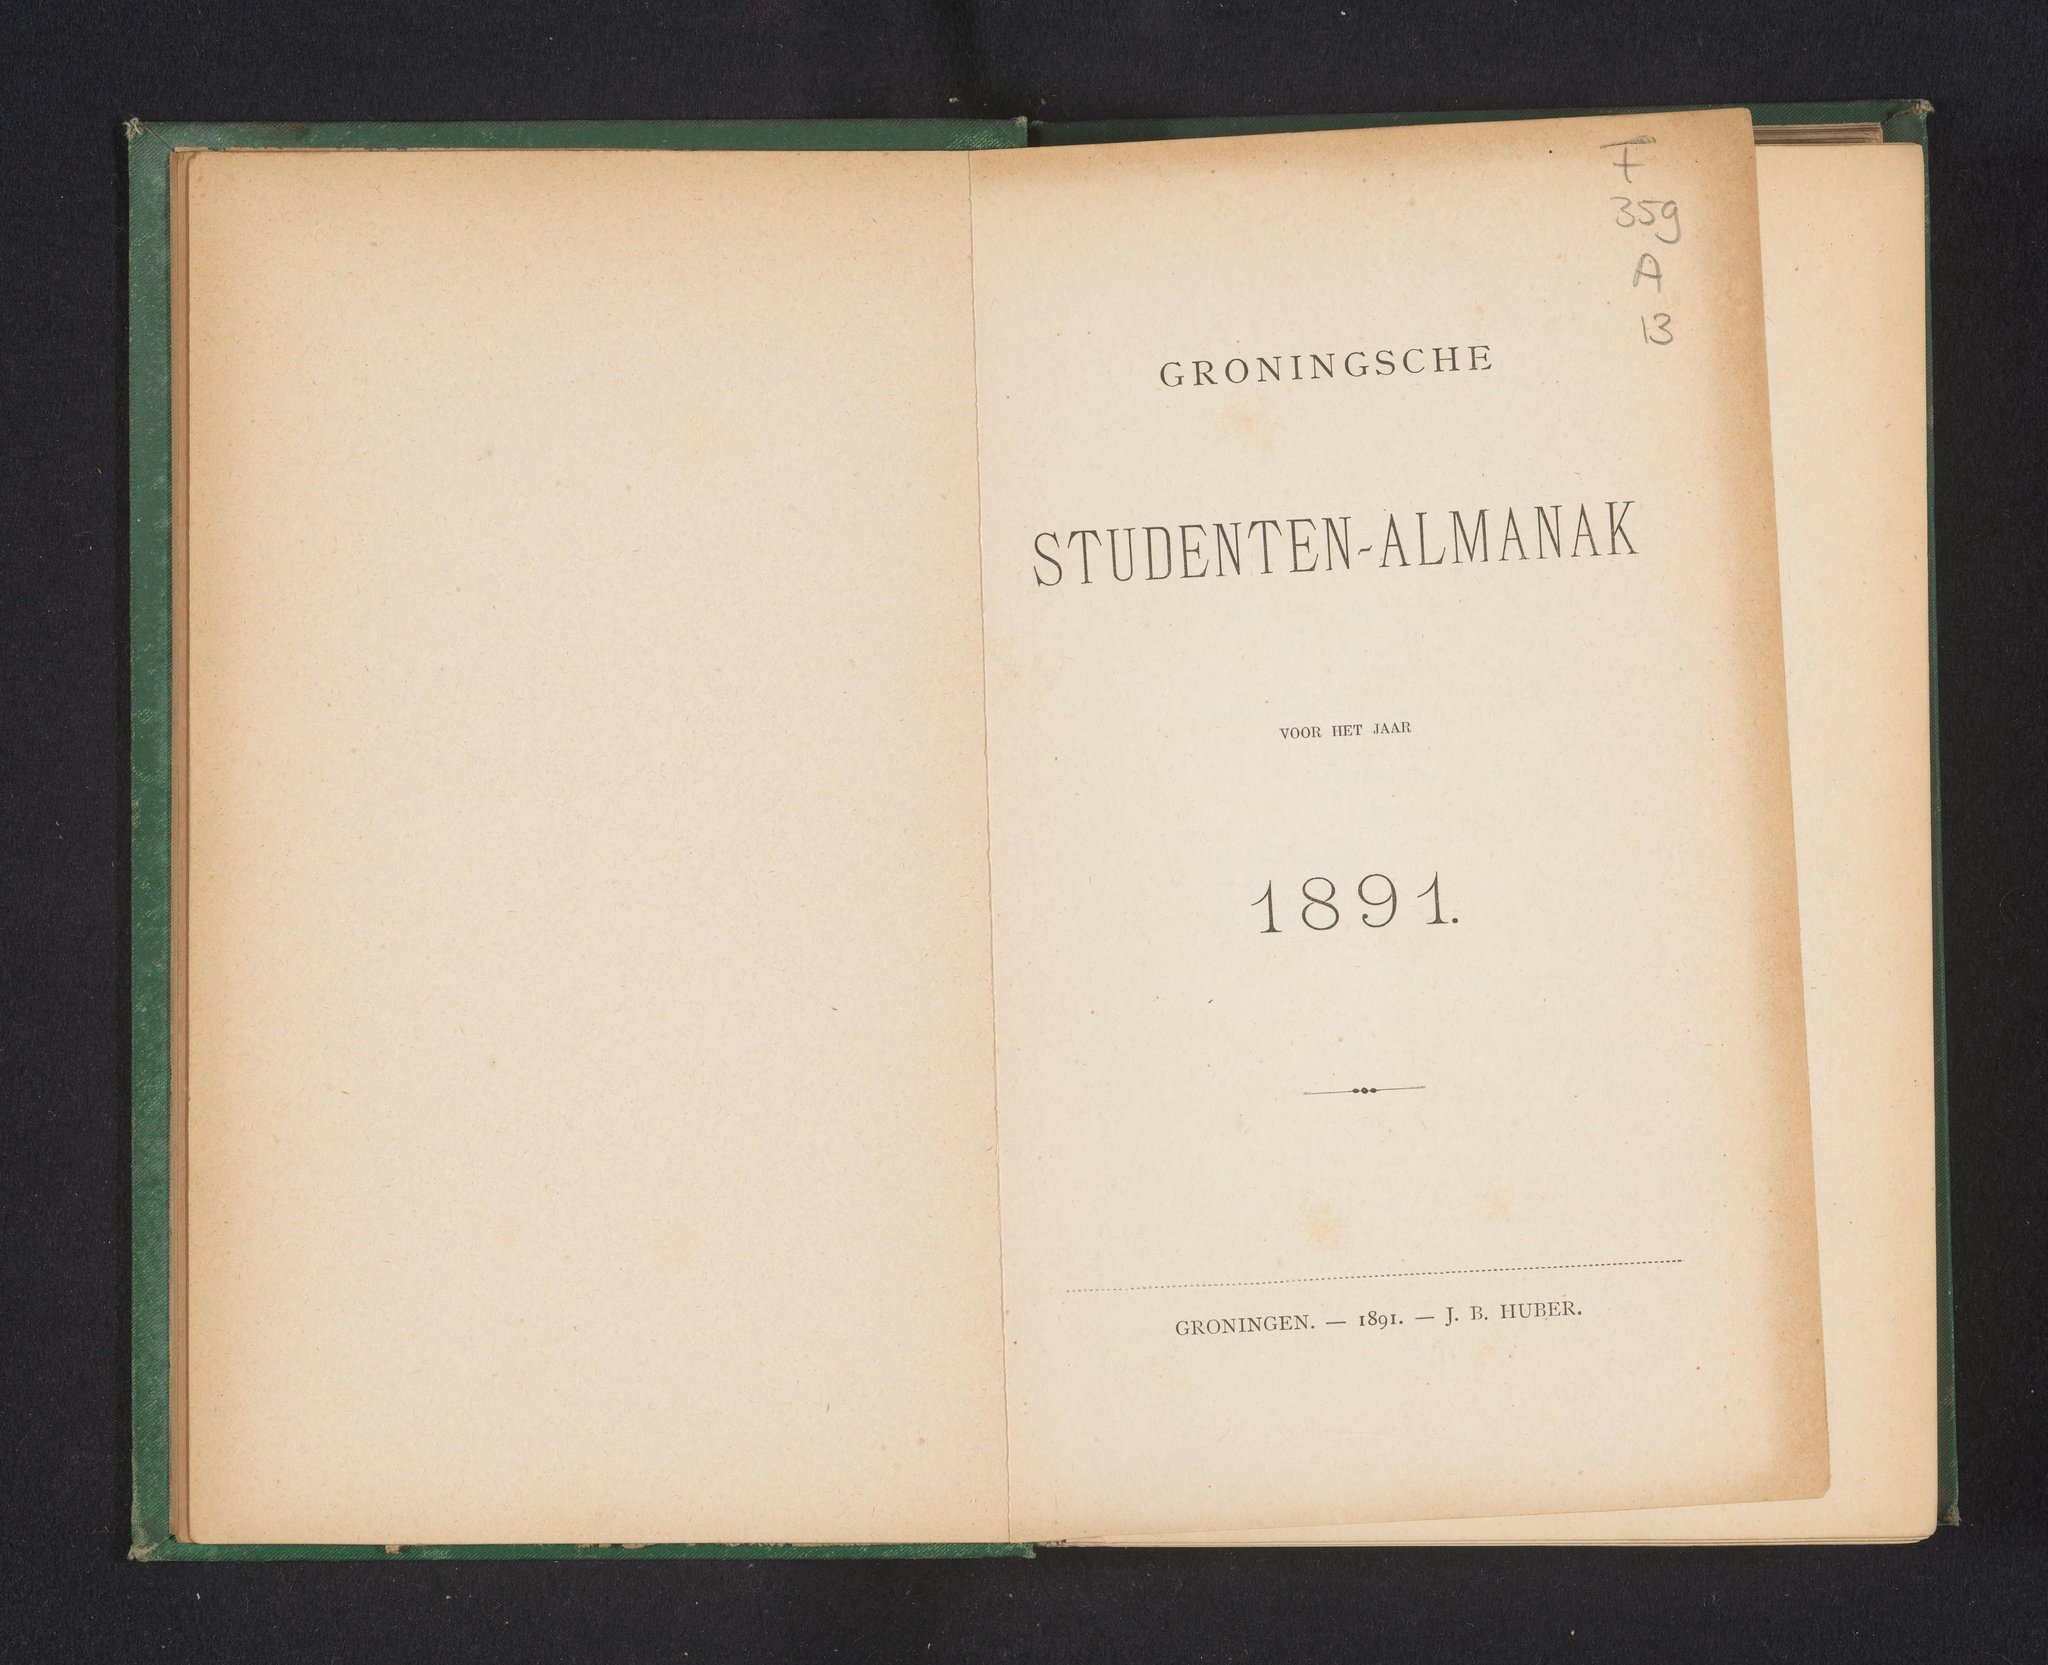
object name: book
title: Groninger studenten almanak voor het jaar 1891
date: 1891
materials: cardboard, linen, paper, photographic support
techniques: albumen print, lithograph, printing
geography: groningen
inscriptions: number: ‘f 3.75’, annotation: ‘gekocht okt 19[..] bij/ Academia, Groningen/ voor f 3.75.’